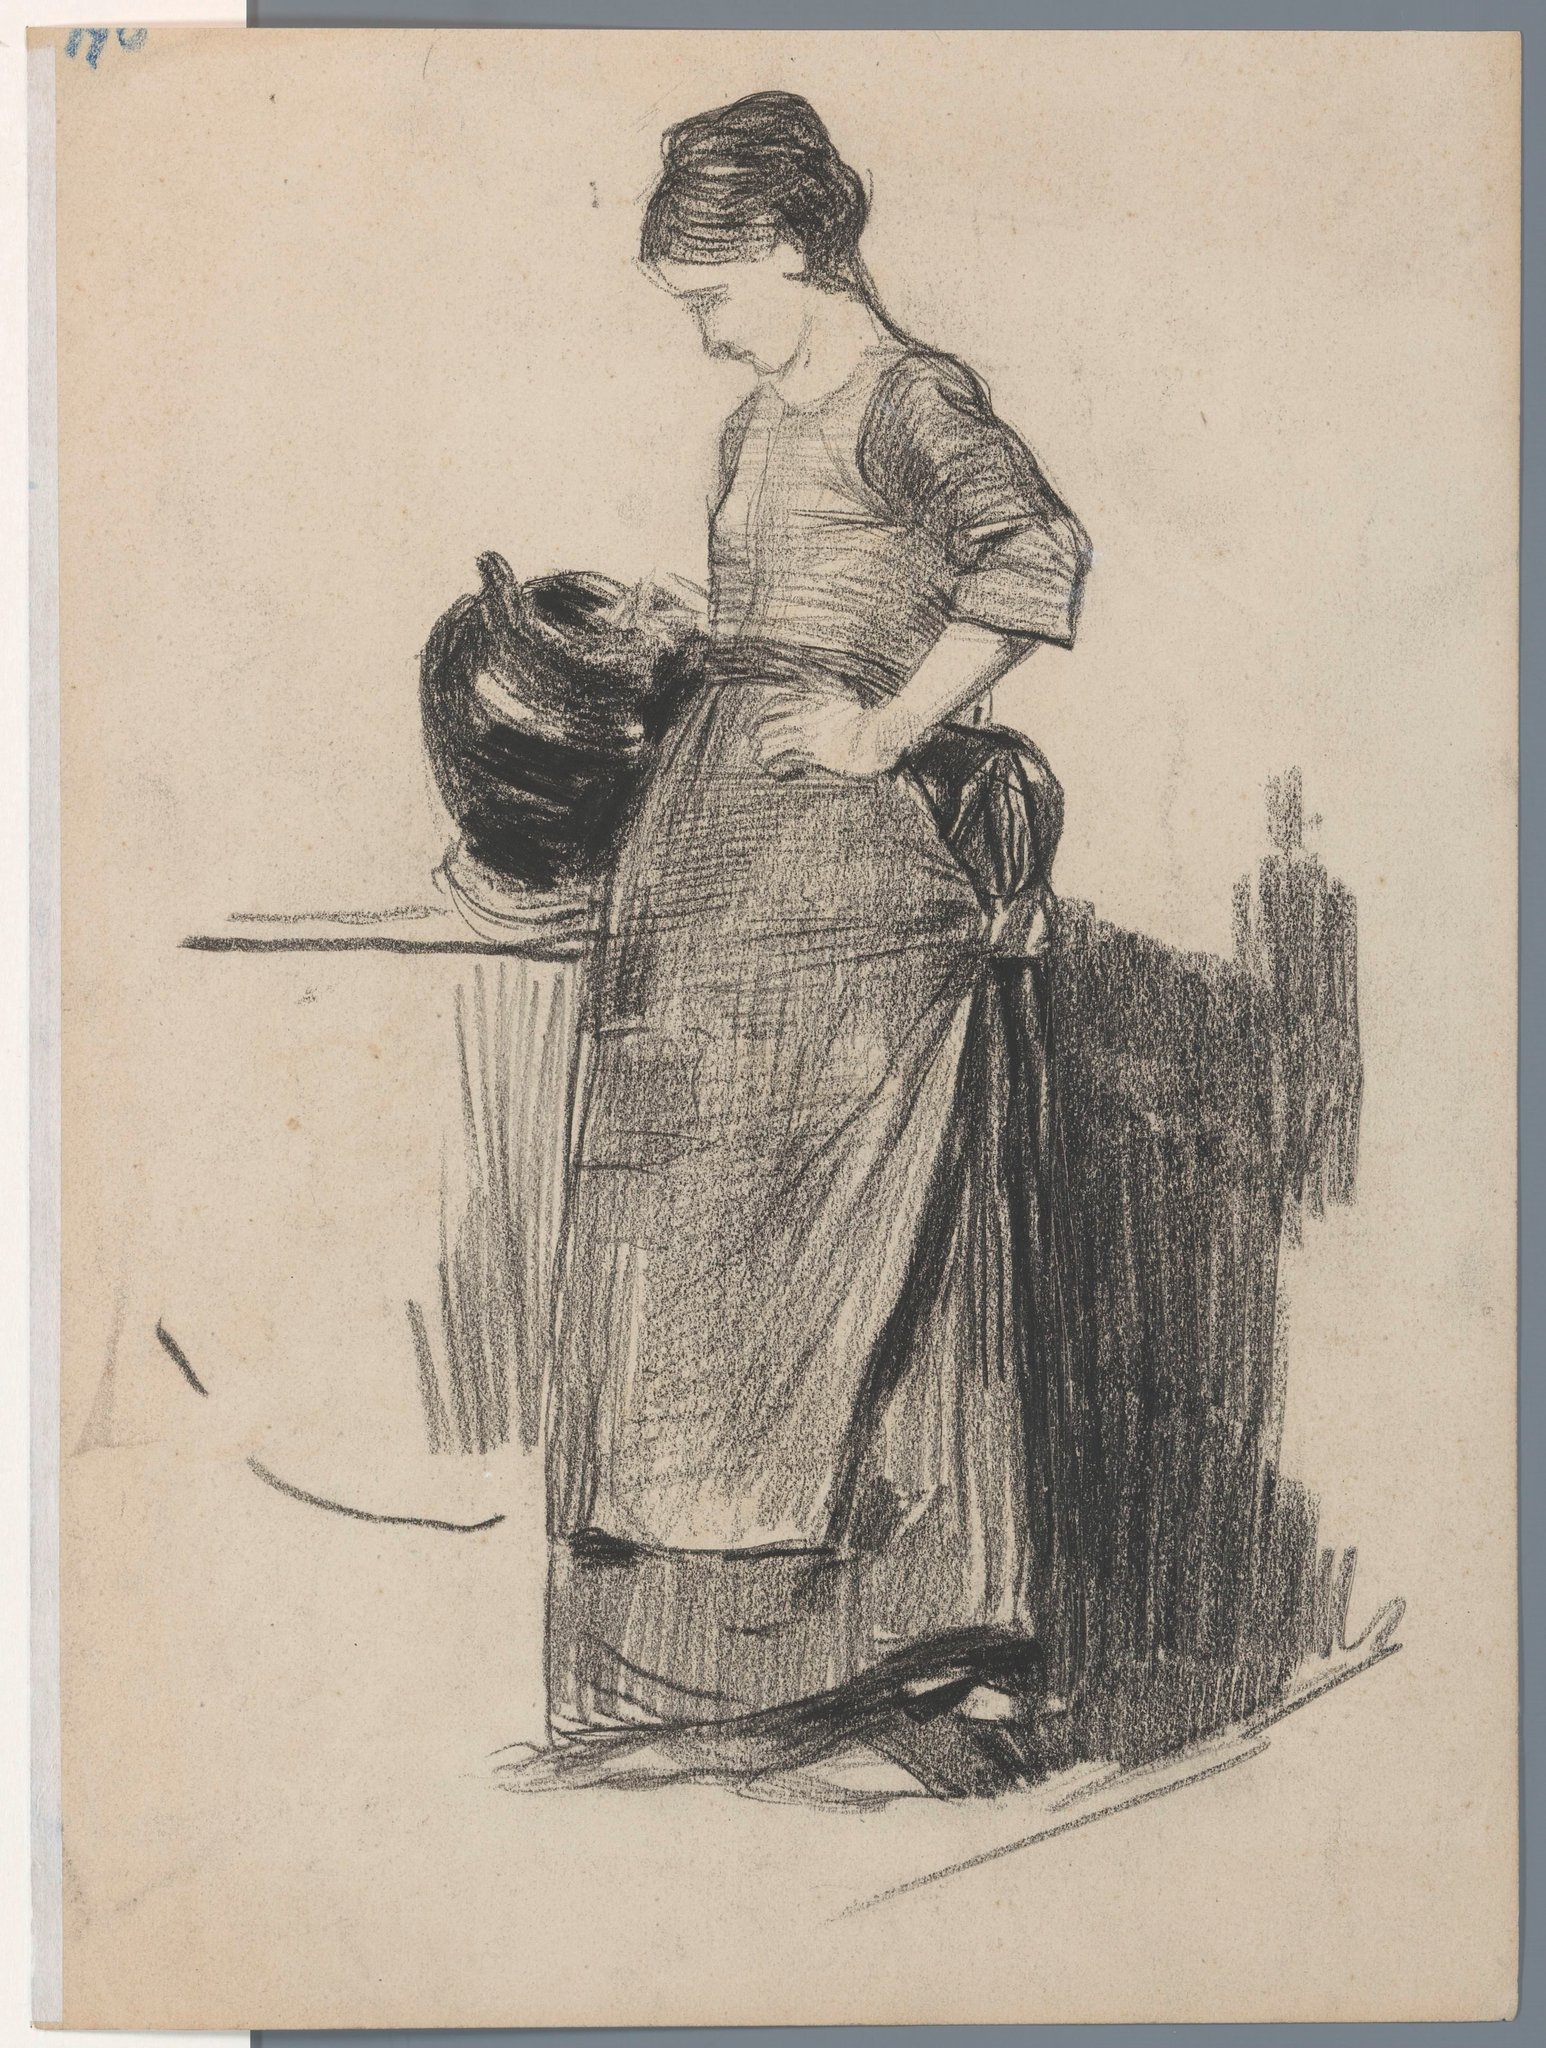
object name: drawing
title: Staande vrouw met kruik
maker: pieter de josselin de jong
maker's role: draughtsman, painter, print maker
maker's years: 1861-1906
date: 1871-1906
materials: chalk, paper